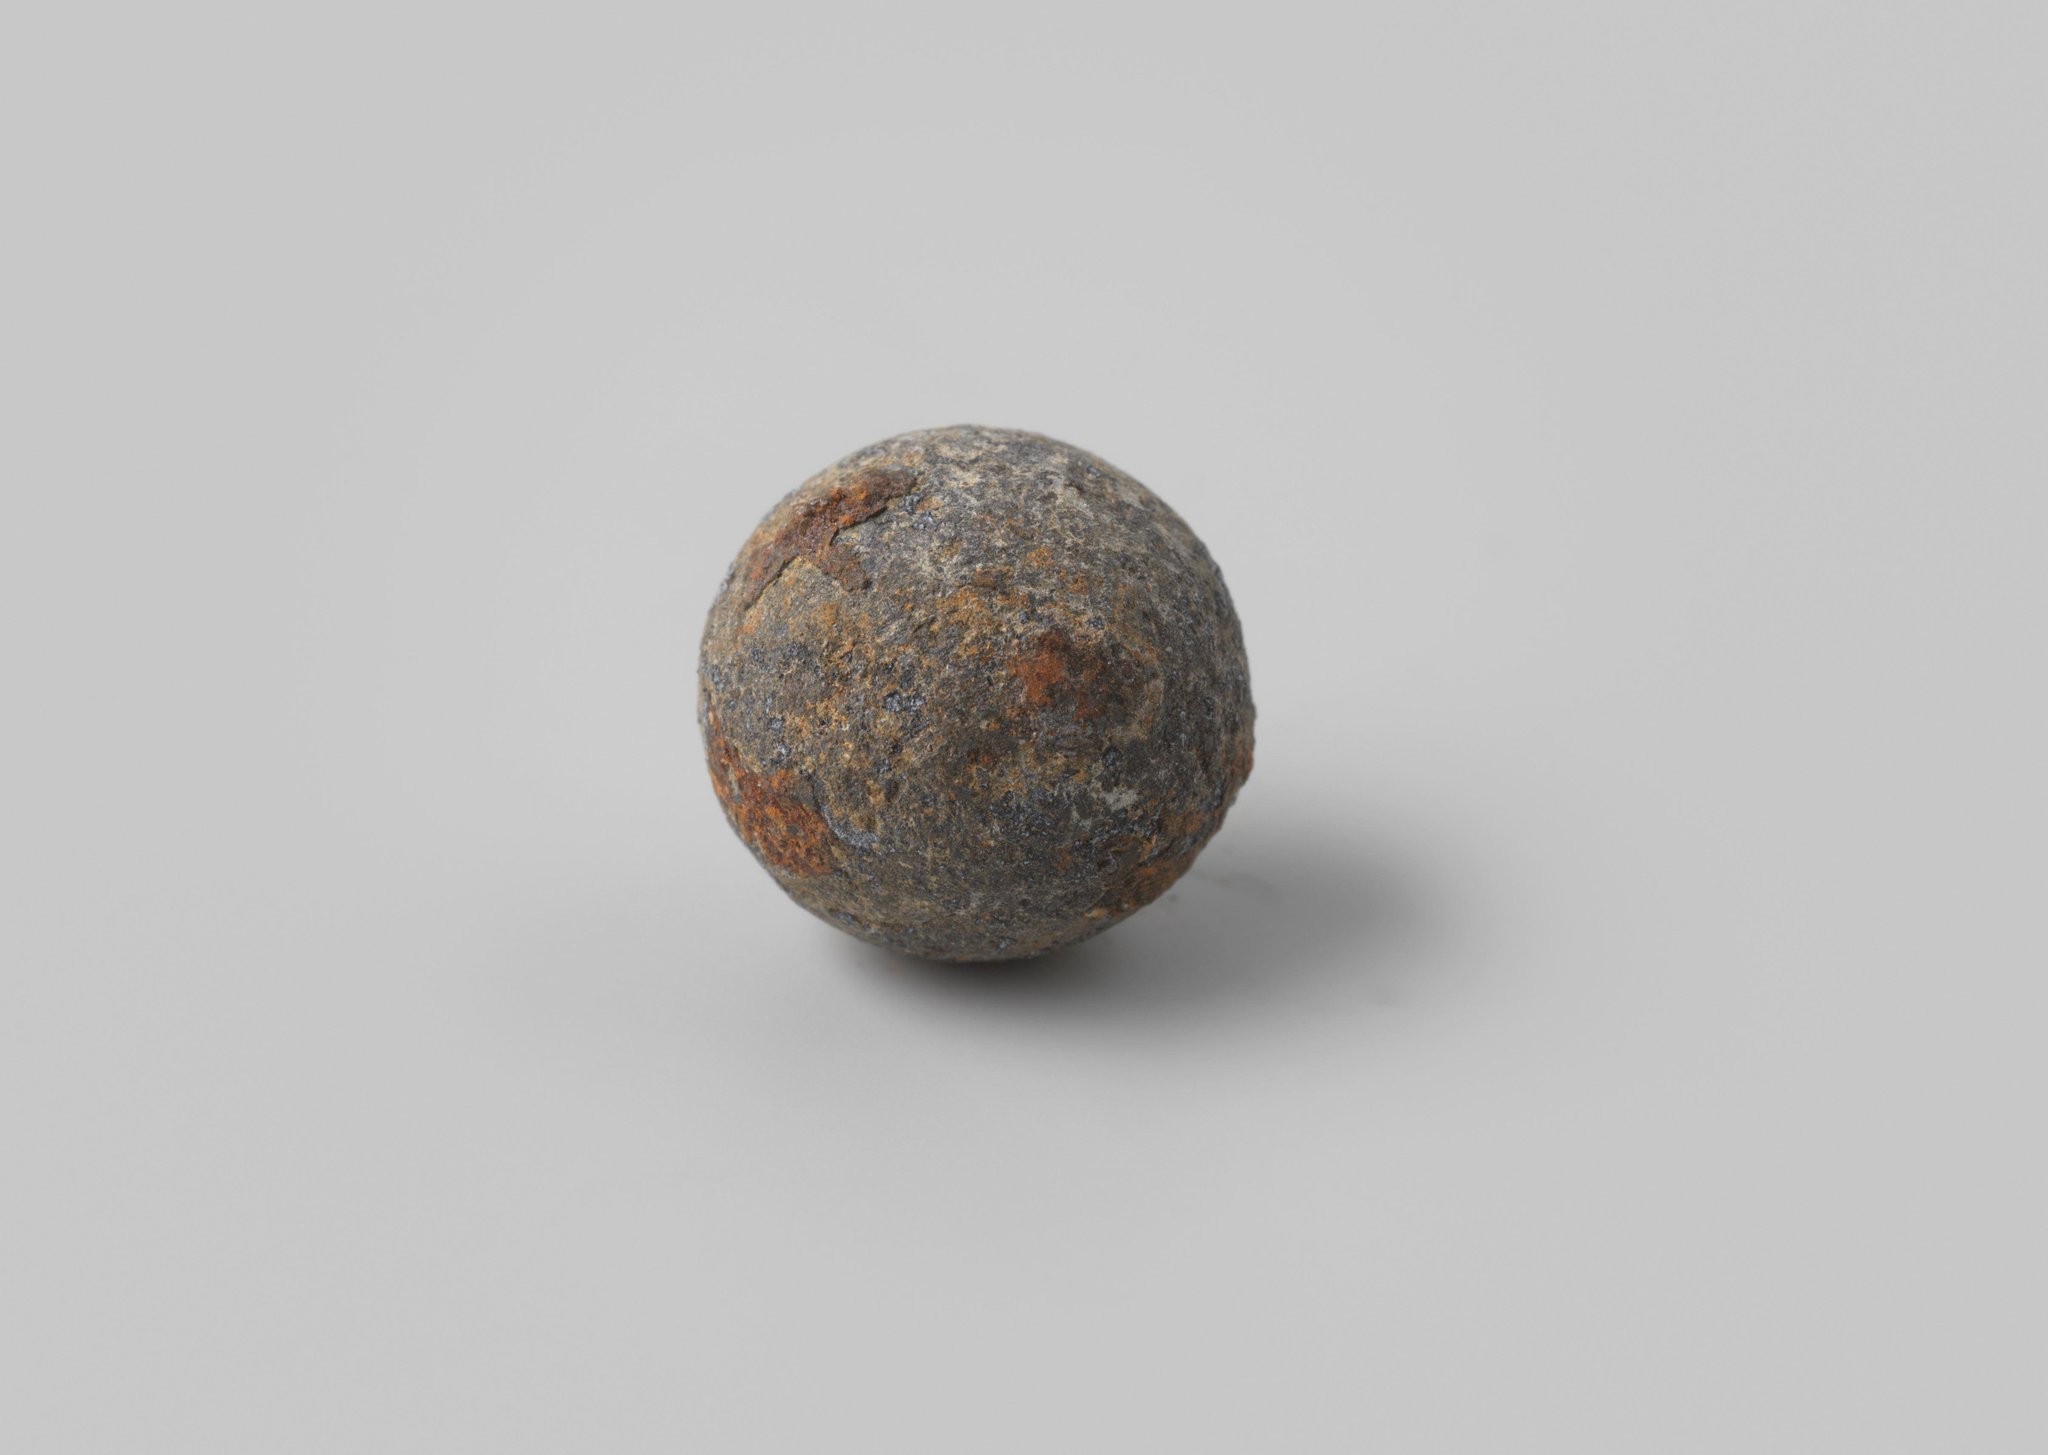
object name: bullet ammunition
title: Pistoolkogel uit het wrak van de Oost-Indiëvaarder Hollandia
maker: Anonymous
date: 1700-1743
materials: lead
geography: netherlands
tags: verenigde oostindische compagnie, hollandia (schip), annet